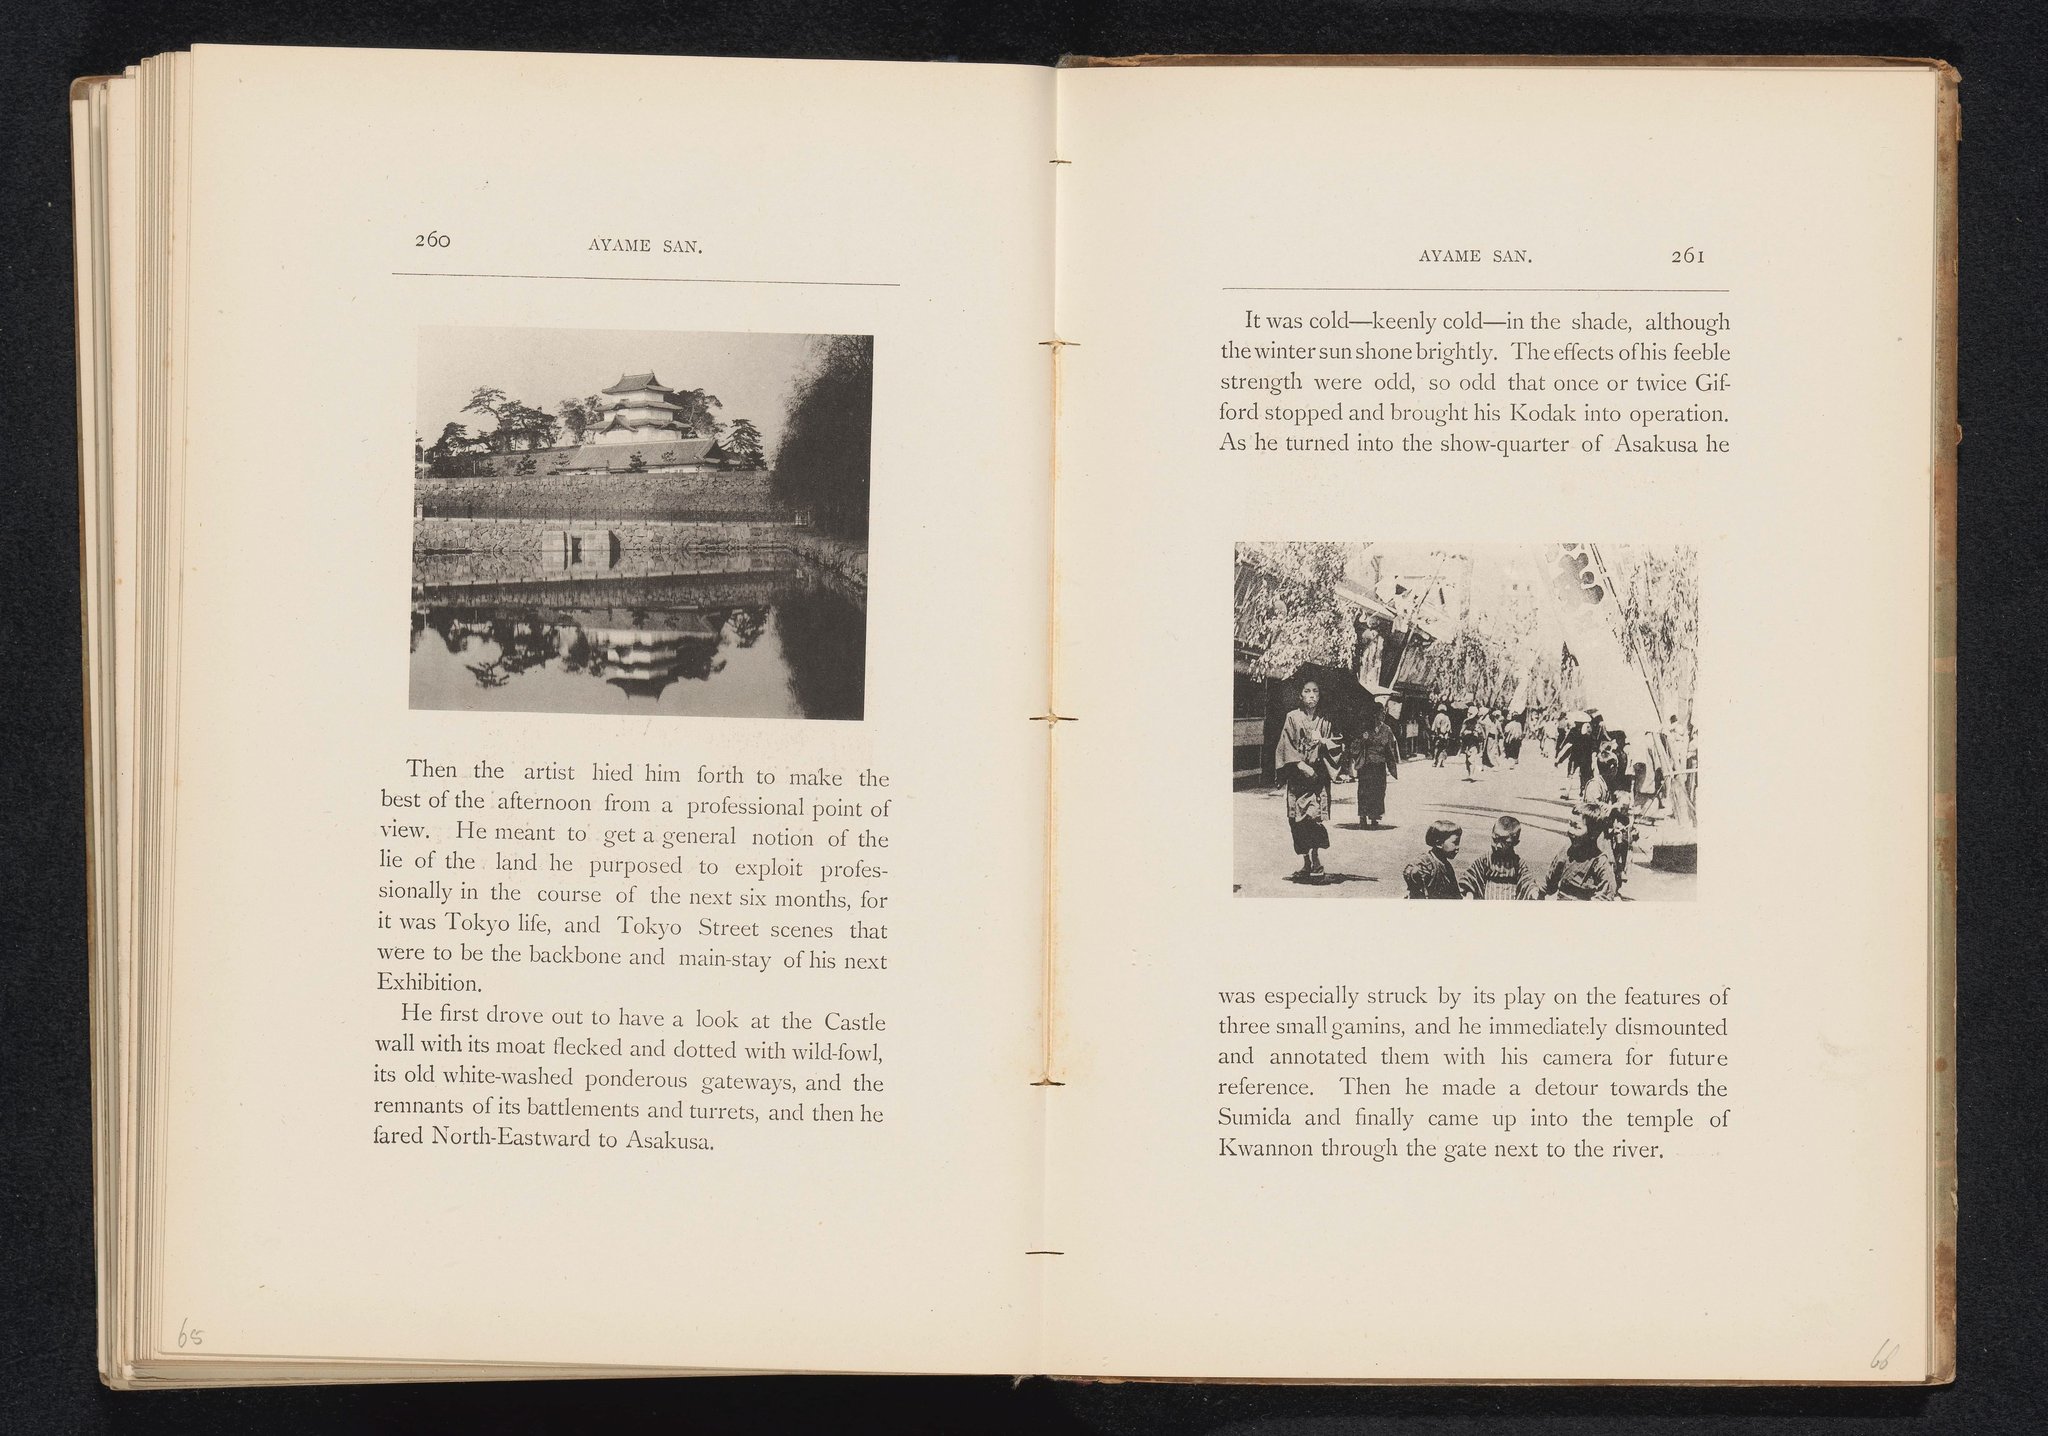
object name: photomechanical print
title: Gezicht op de Kokyo te Tokyo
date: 1882-1892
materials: paper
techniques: photograph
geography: japan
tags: palace, façade (of house or building)